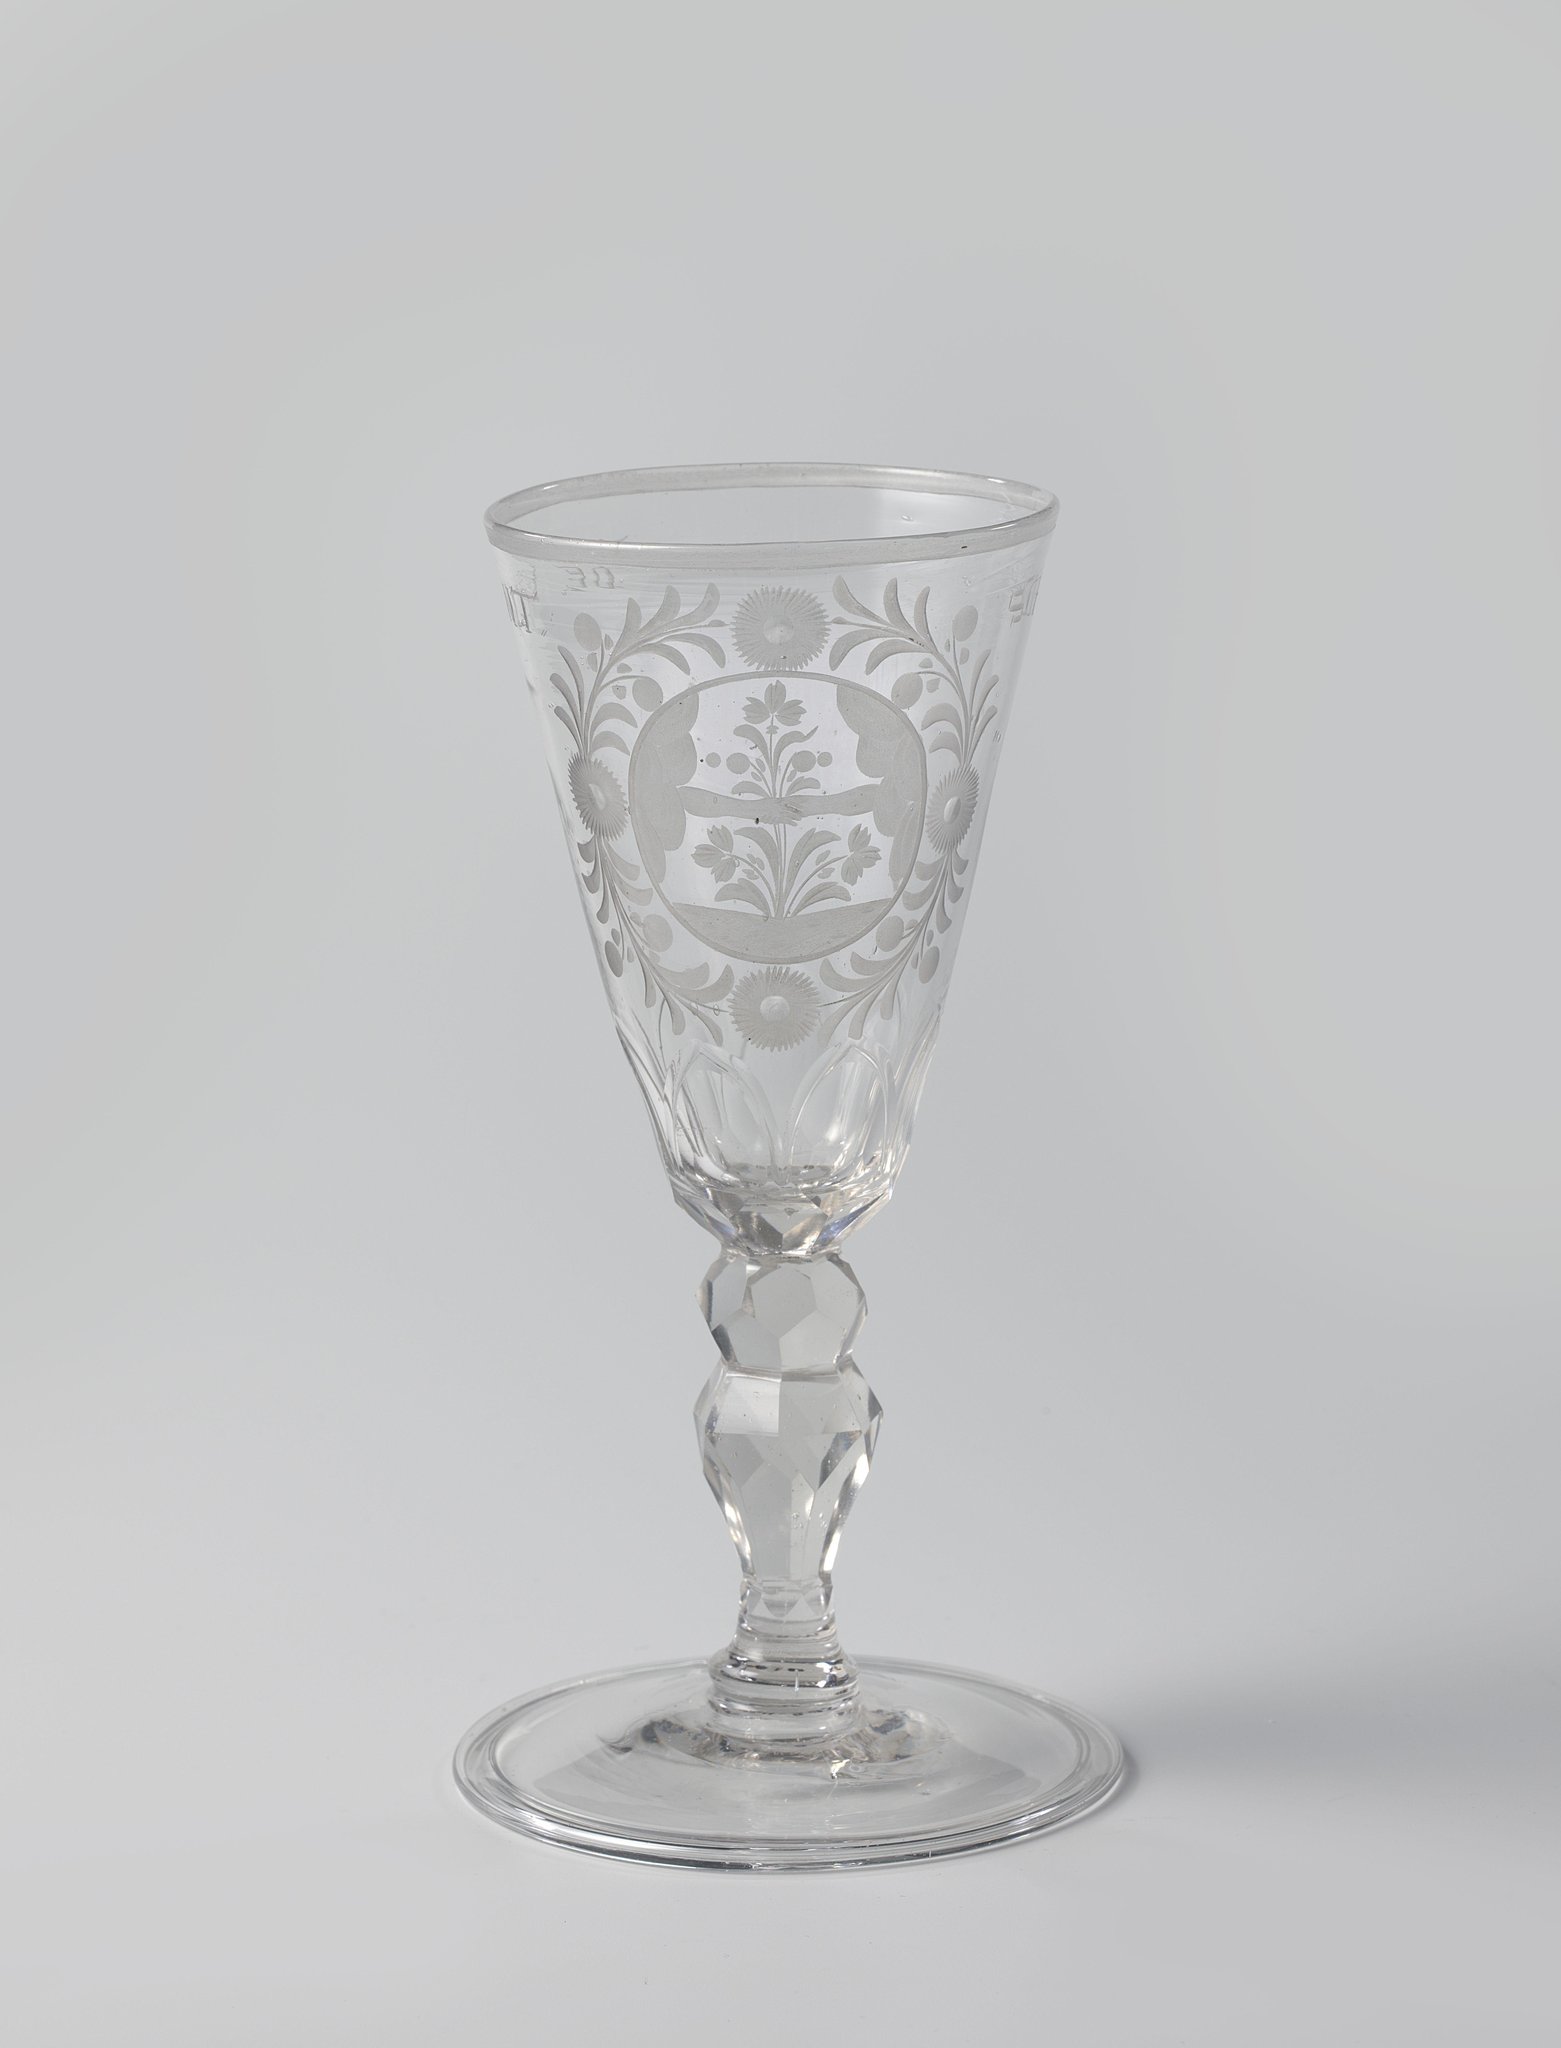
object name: goblet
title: Bokaal met twee ineengelegde handen en het opschrift: DE VRINT SCHAP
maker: Anonymous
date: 1725-1750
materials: glass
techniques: glassblowing, grinding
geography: northern netherlands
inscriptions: inscription: ‘DE VRINT SCHAP’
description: Platte voet. Gefacetteerde balusterstam met twee knopen. Conische kelk met gefacetteerde, afgeronde bodem. Op de kelk, in een rond medaillon omgeven door vier bladertakken, met elkaar verbonden door vier ronde bloemen, twee ineen geslagen handen, die uit wolken tevoorschijn komen, voor een bloeiende plant. Ter weerszijden van het medaillon, langs de mondrand de tekst: DE VRINT SCHAP.